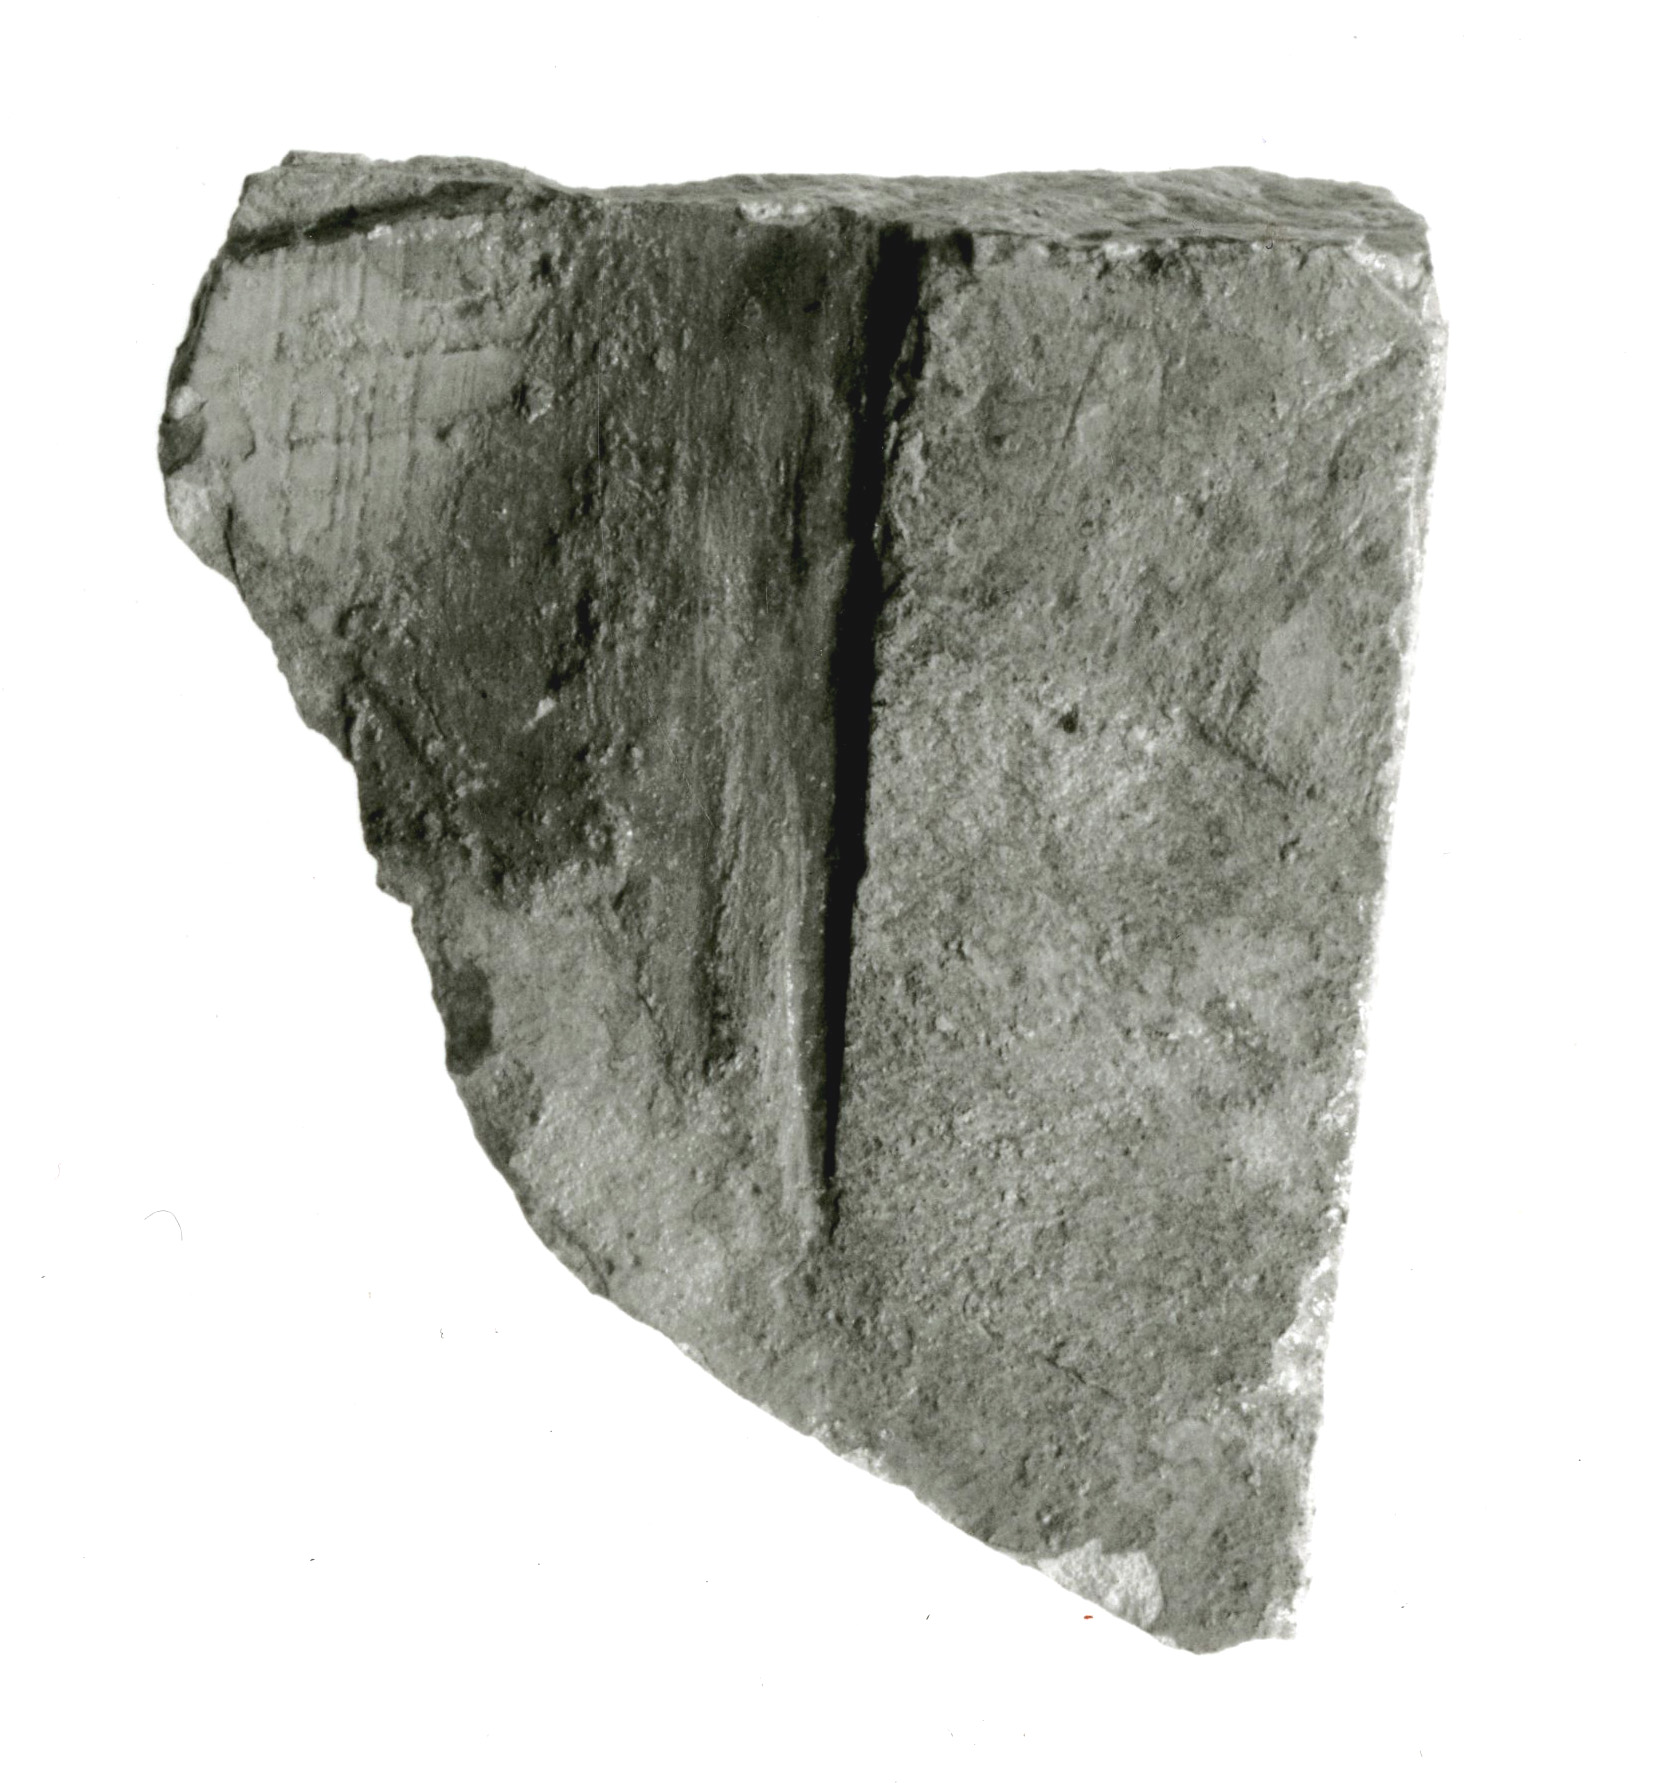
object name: relief, tomb of nespekashuty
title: Raised relief fragment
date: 664-610 BCE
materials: limestone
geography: egypt